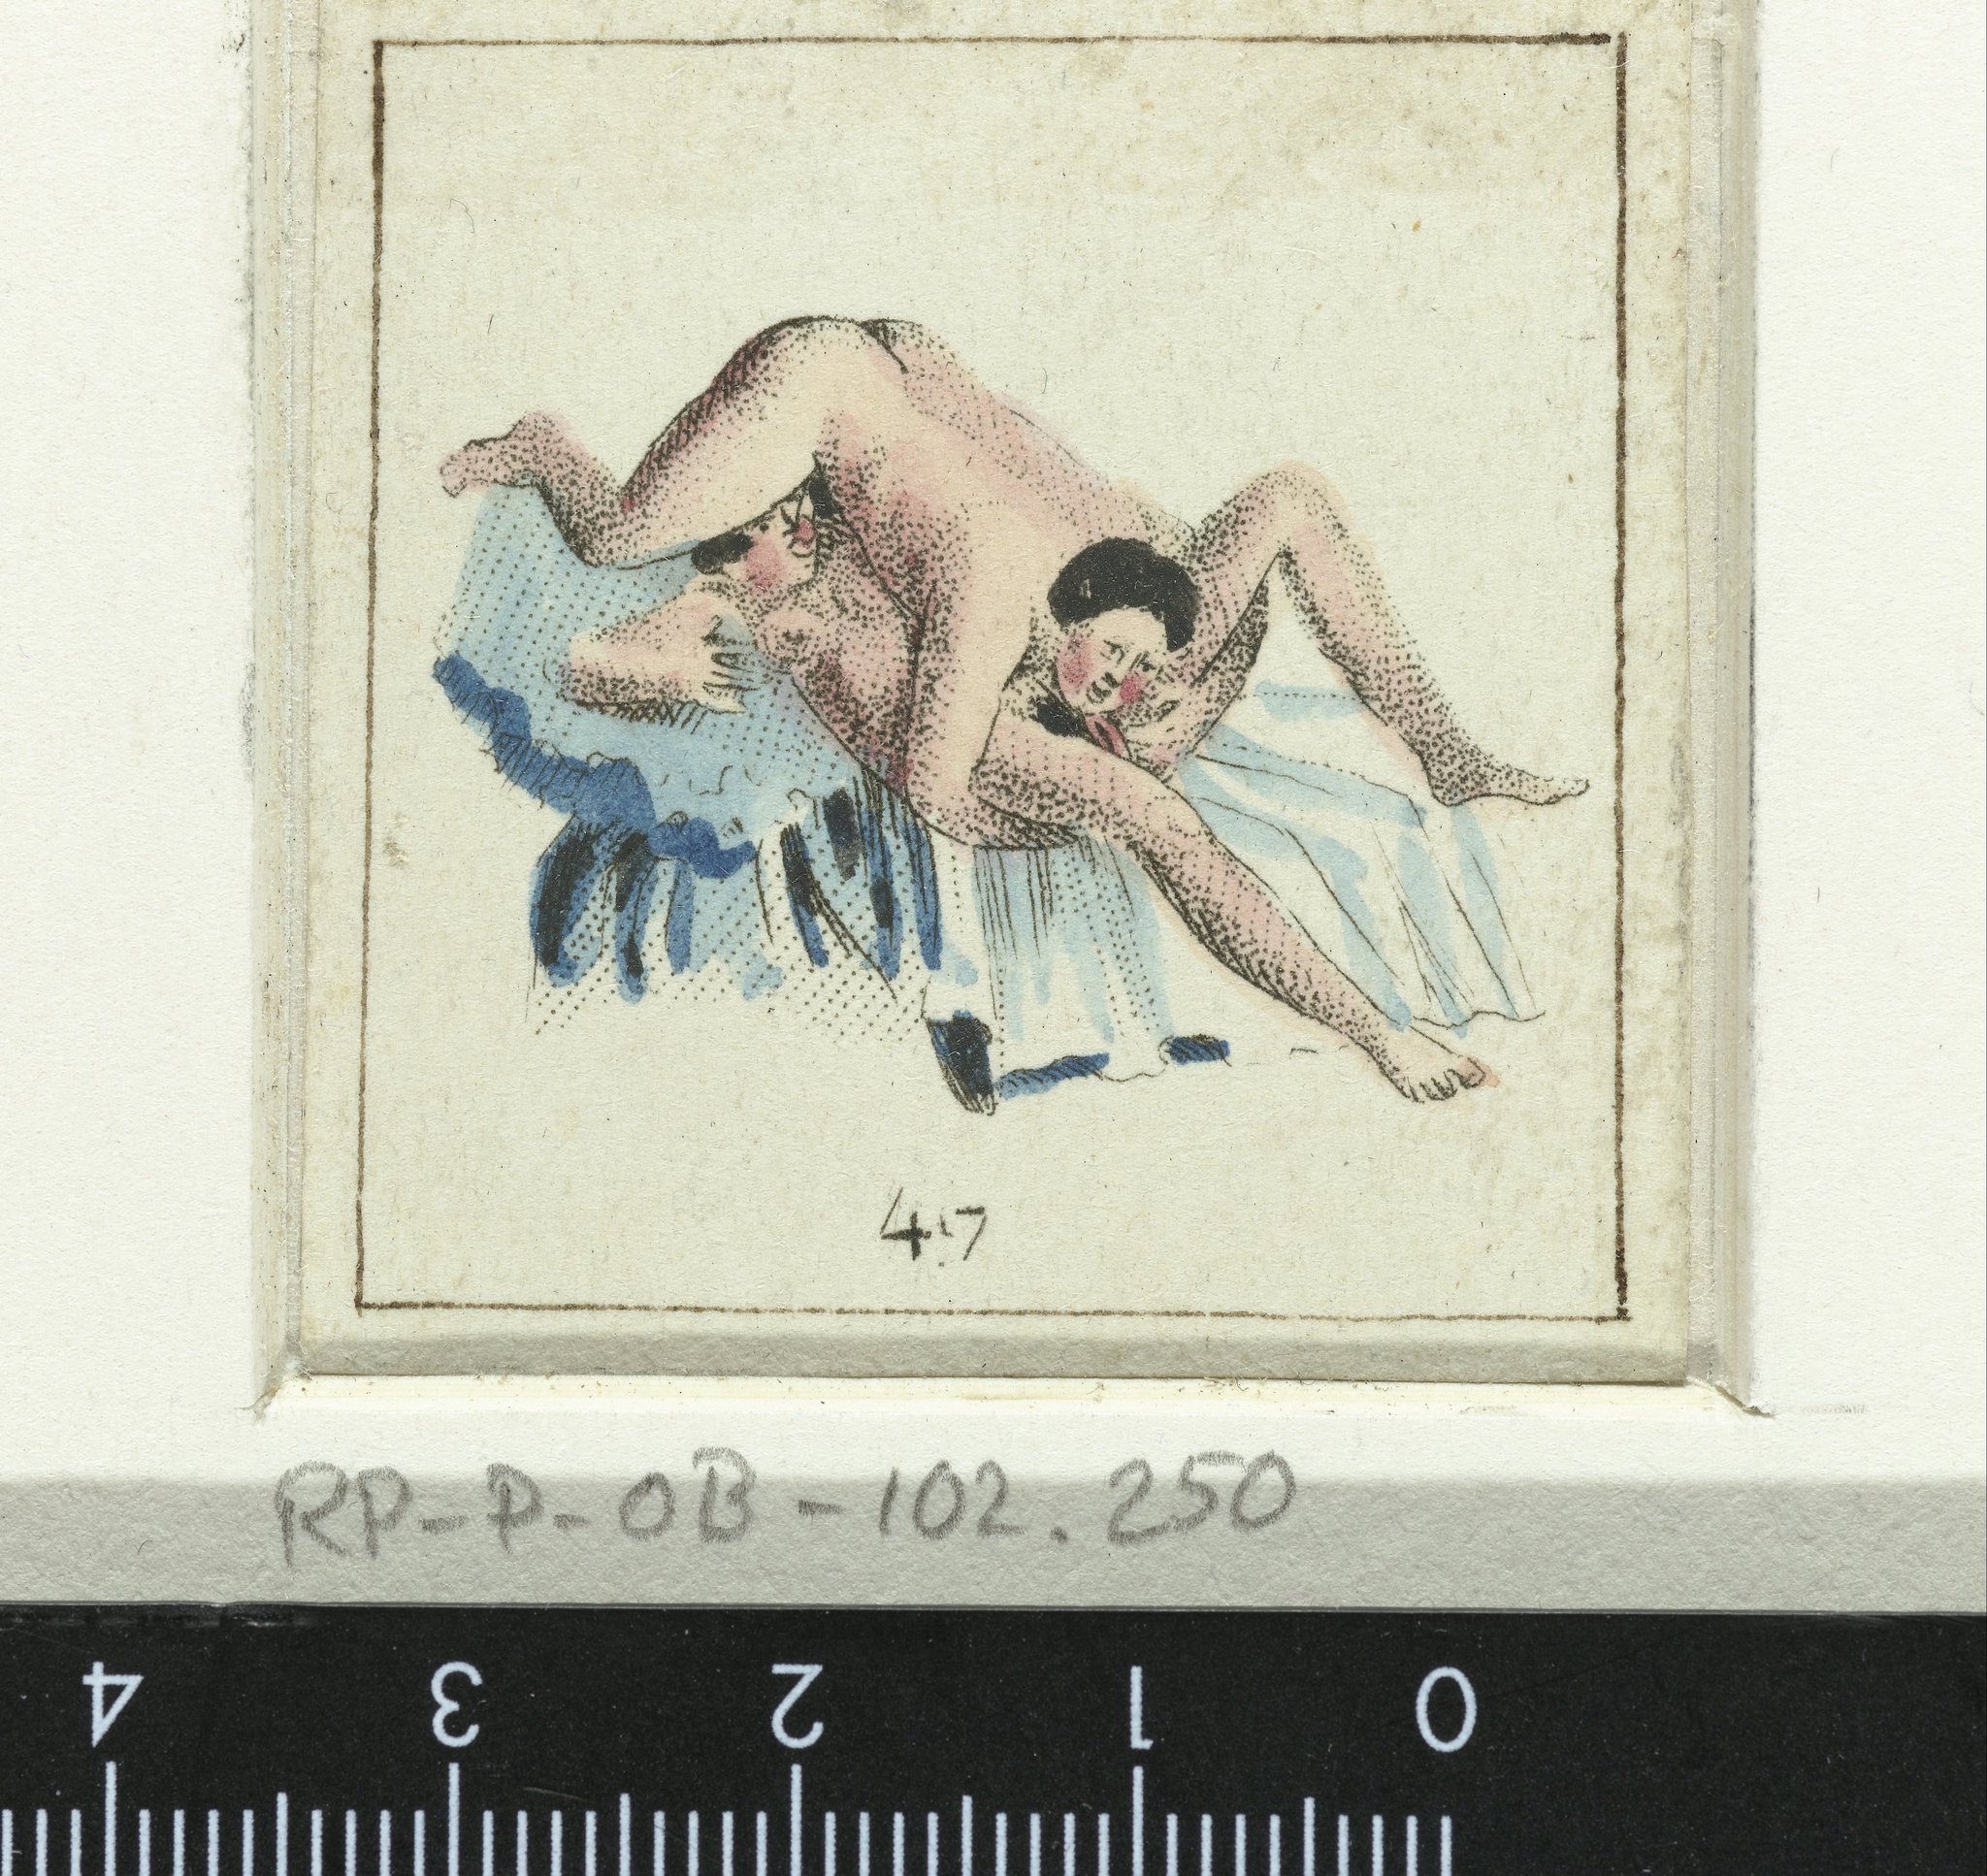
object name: print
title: Acht erotische scène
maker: Anonymous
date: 1750-1850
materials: paper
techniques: etching, hand coloring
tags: man and woman cohabiting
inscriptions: number: ‘47’